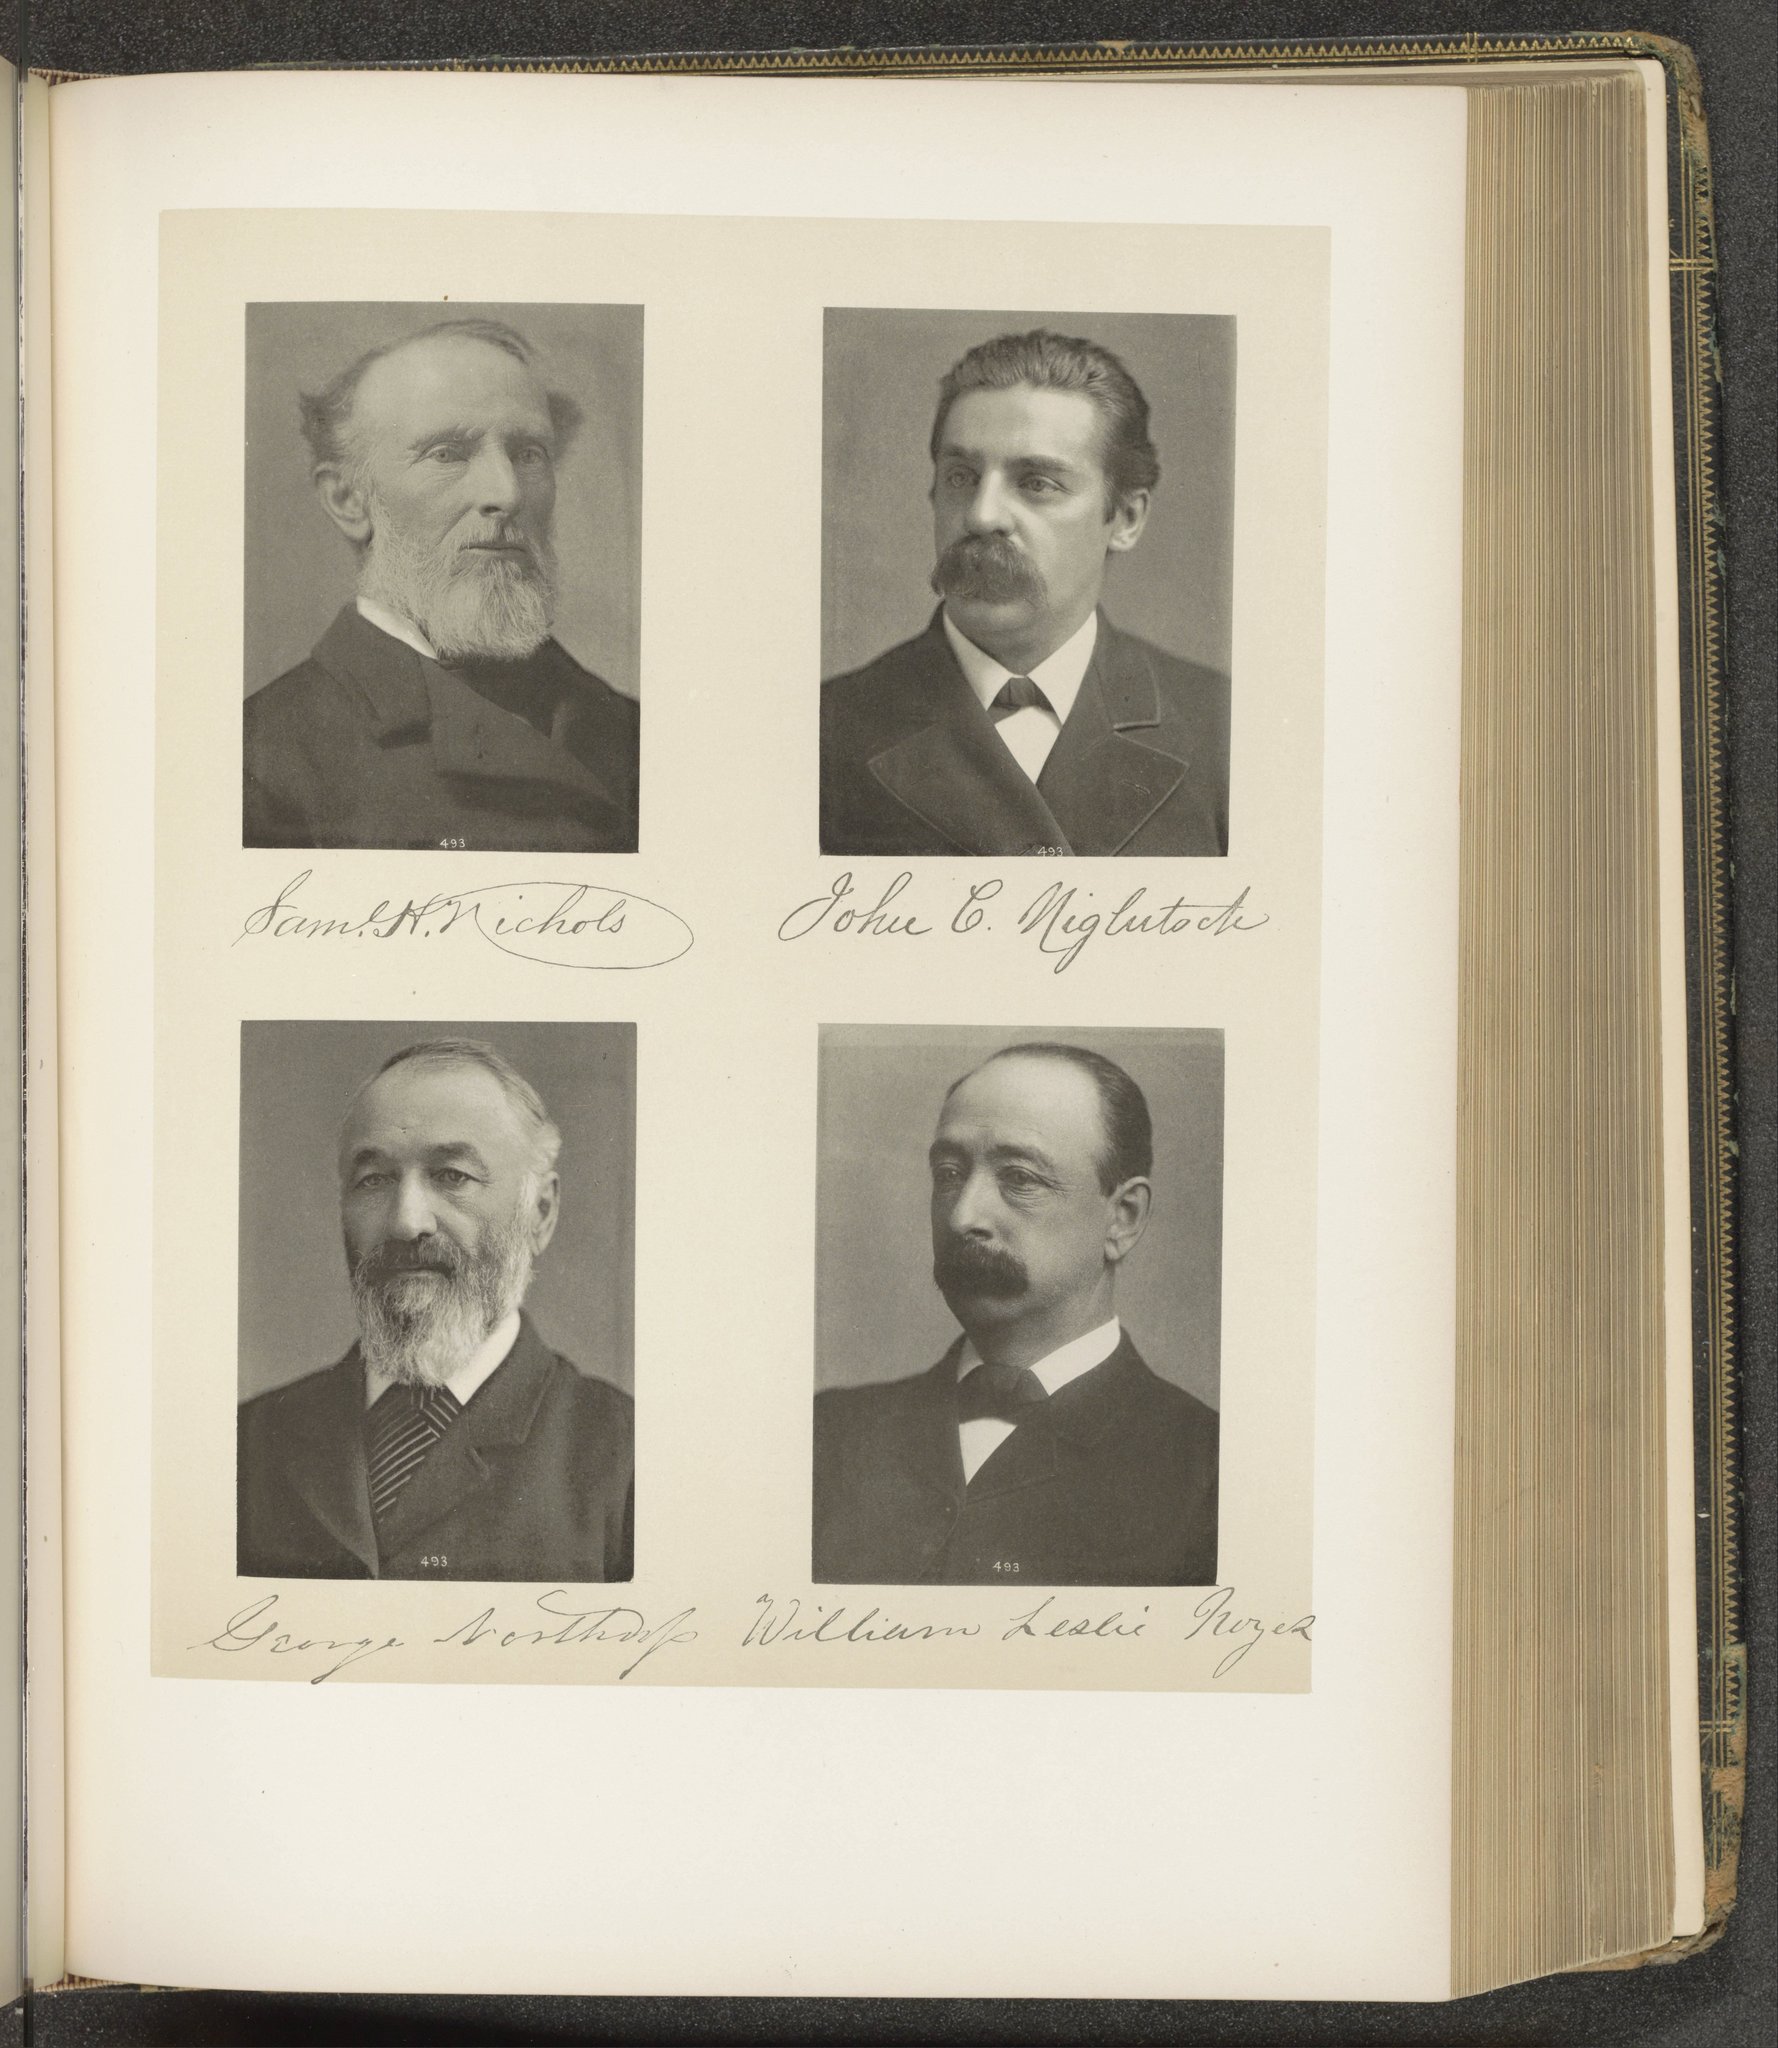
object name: photomechanical print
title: Portretten van vier leden van het Lagerhuis van de staat New York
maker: Anonymous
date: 1872-1882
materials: paper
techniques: photograph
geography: united states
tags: historical persons (portraits and scenes from the life) (+ head (and shoulders) (portrait))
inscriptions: annotation, number: ‘493’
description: Linksboven Samuel Hamilton Nichols, rechtsboven John C. Niglutsch, linksonder George Northup, rechtsonder William Leslie Noyes.